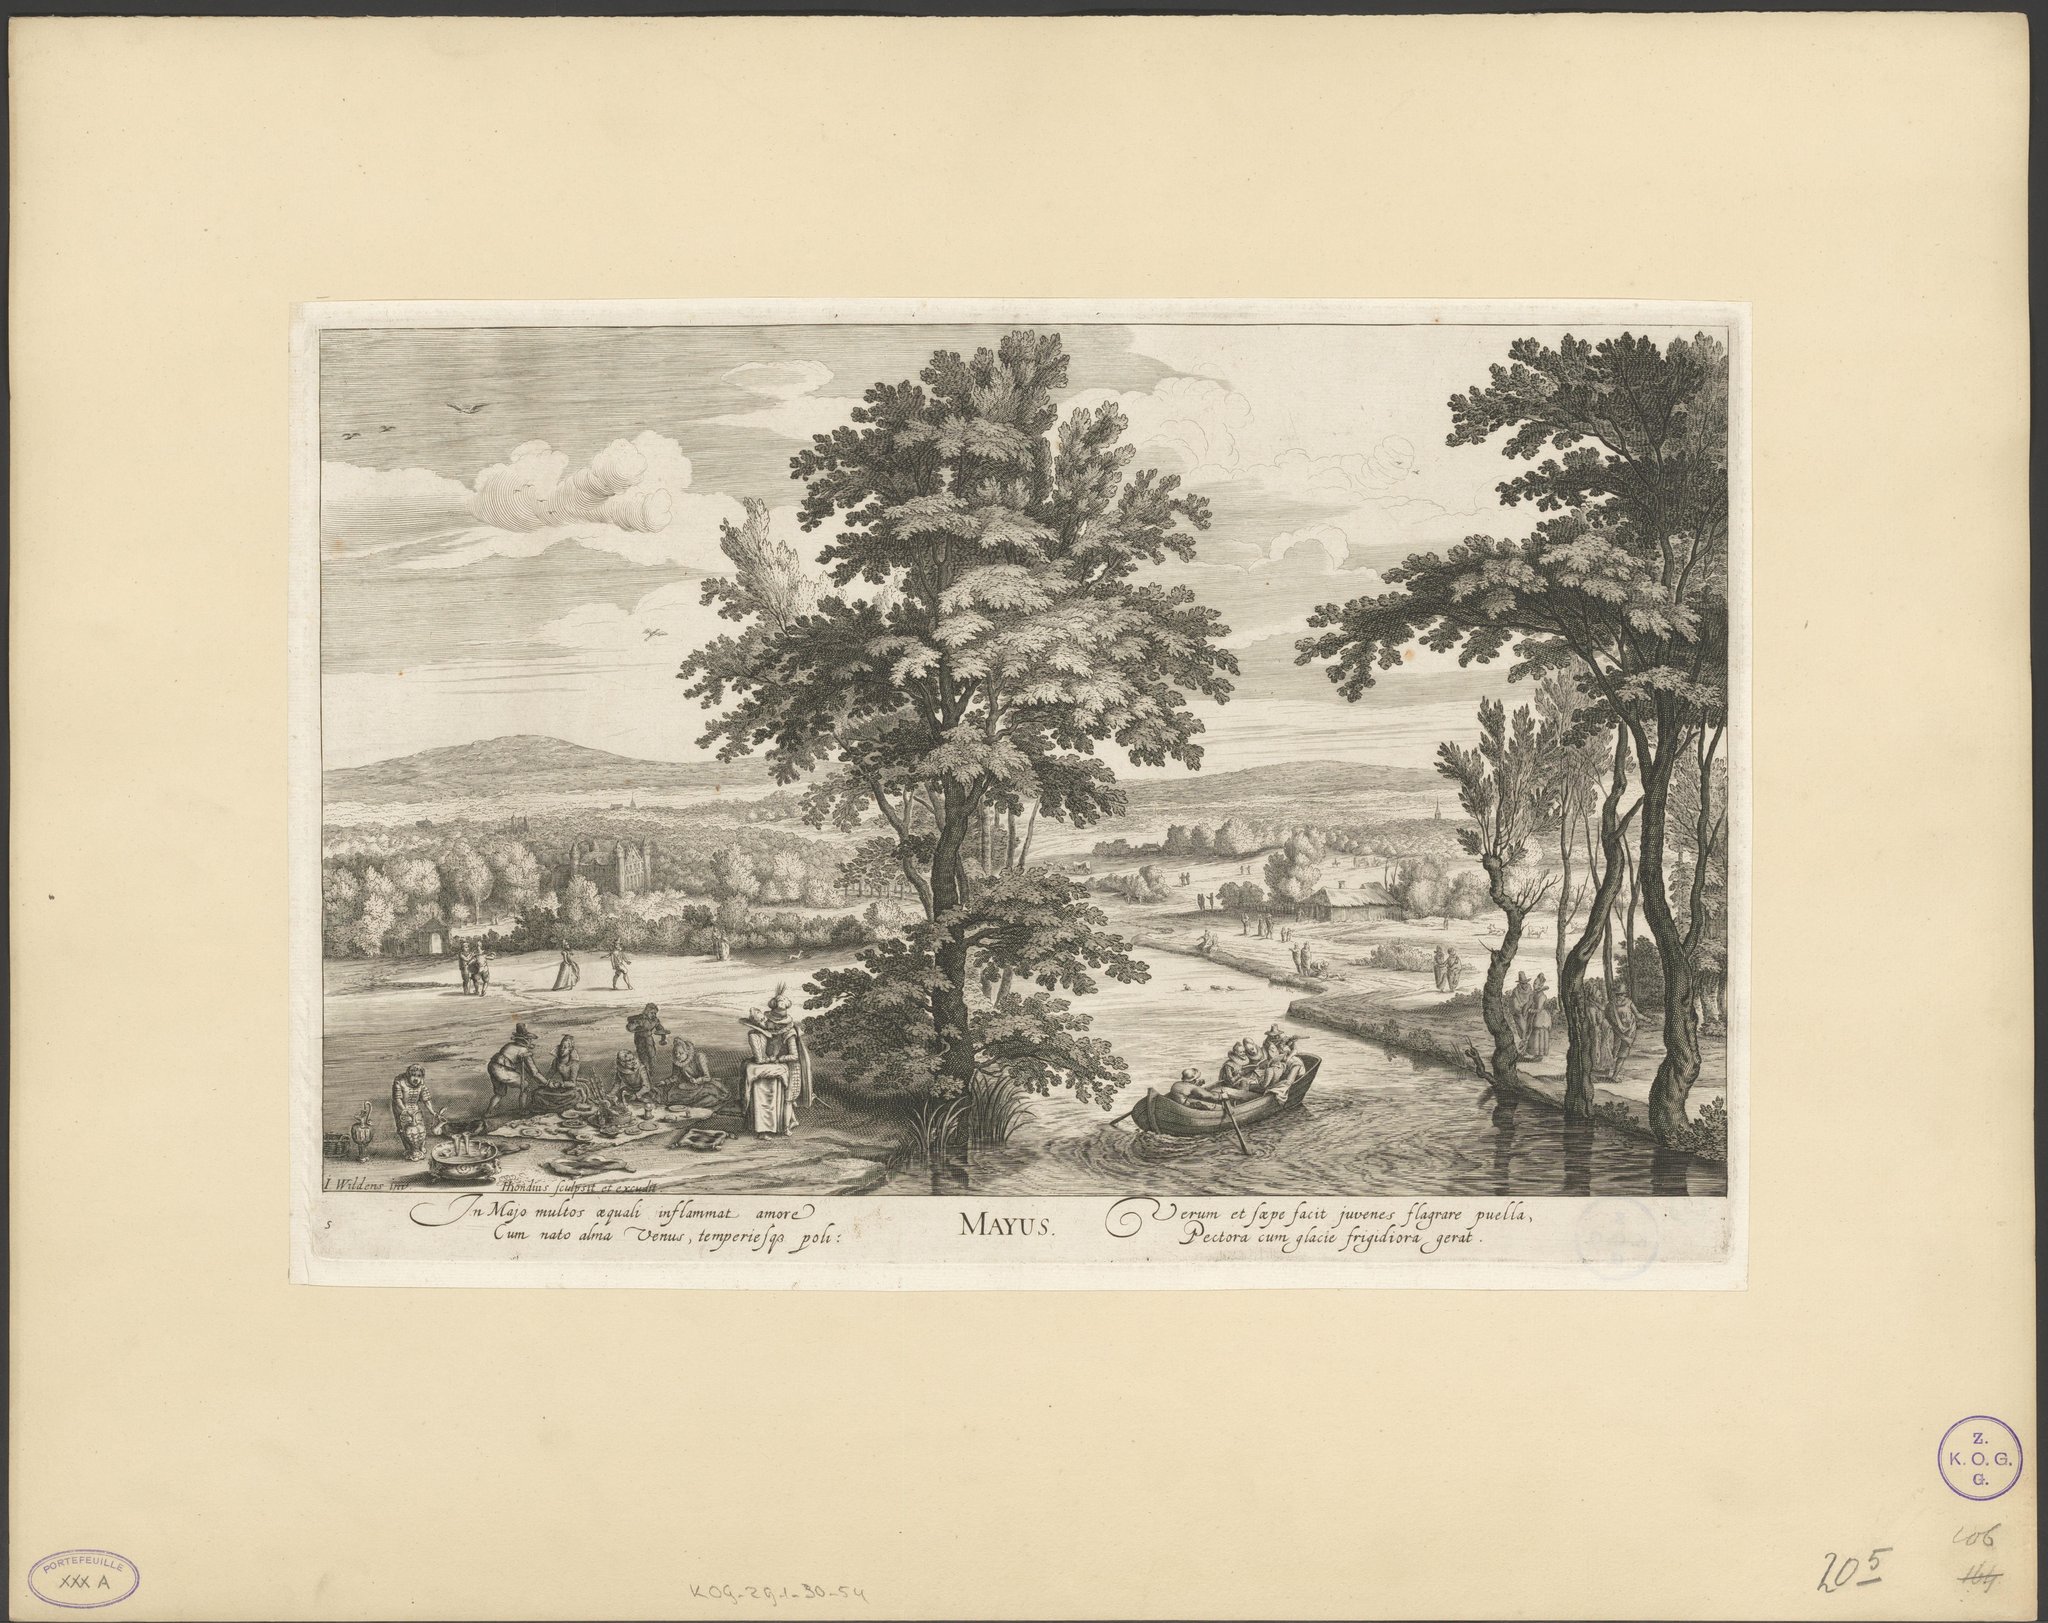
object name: print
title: Mayus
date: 1614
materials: paper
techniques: engraving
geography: the hague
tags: may and its 'labours', picnic, alfresco, 'déjeuner sur l'herbe', open-air recreation, rowing, canoeing, etc. (sport), landscape symbolizing may (+ with scenes showing human occupations ~ seasons and months)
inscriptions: collector's mark: Lugt 1641, stamp, stamp: 963, collector's mark: Lugt 1641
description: Landschap met grote boom in het midden op de voorgrond, rechts een rivier en links een weiland met bosrand. Op de rivier een roeibootje met zingend gezelschap. Op de voorgrond een picknick van een elegant gezelschap. Geheel rechts wandelende paren tussen de bomen. Onder de voorstelling een tekst in het Latijn. Prent uit een serie van de twaalf maanden. Onderwerpsrubrieken binnen de Atlas Zeden en Gewoonten: Zeden en Gewoonten in engeren zin. Volksleven. Zinnebeeldige voorstellingen uit het volkleven op serieprenten. Maanden en diversen (allegorieën).